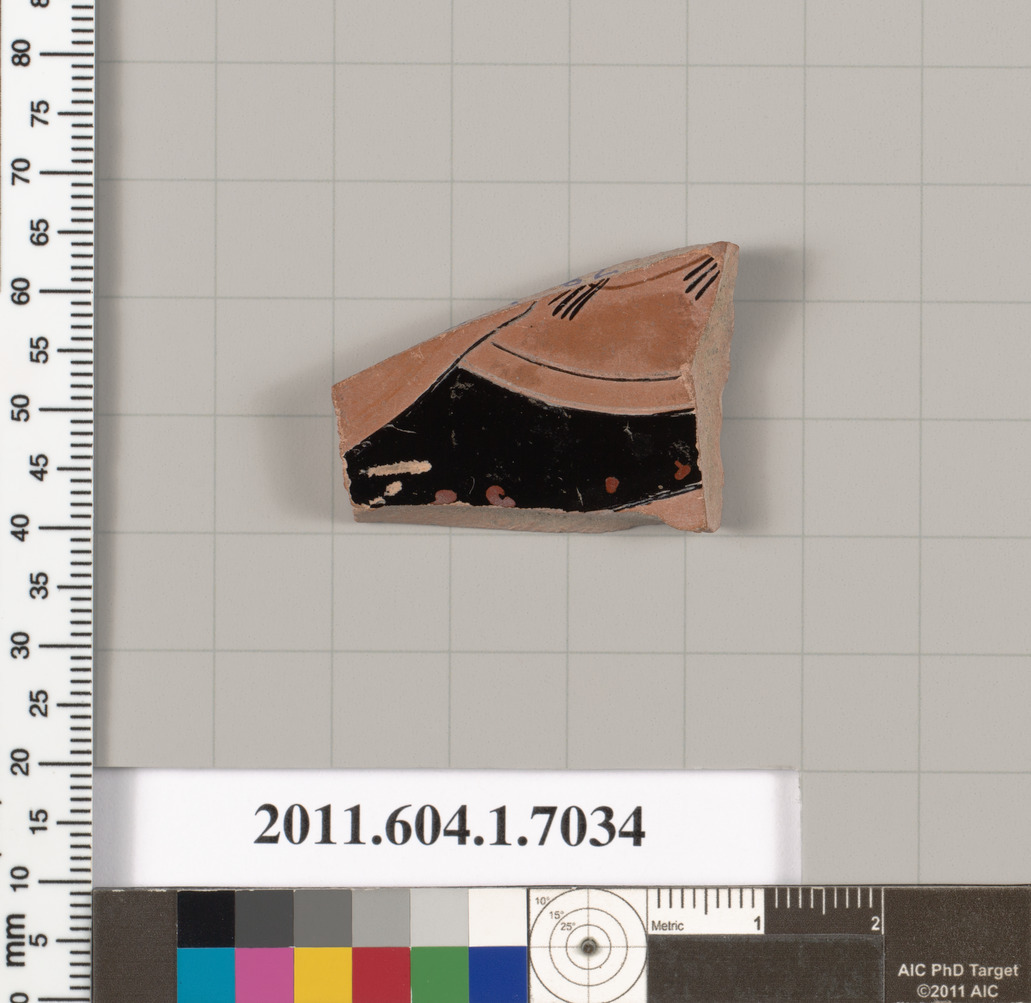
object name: kylix fragment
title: Terracotta fragment of a kylix (drinking cup)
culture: greek, attic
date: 500-480 BCE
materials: terracotta